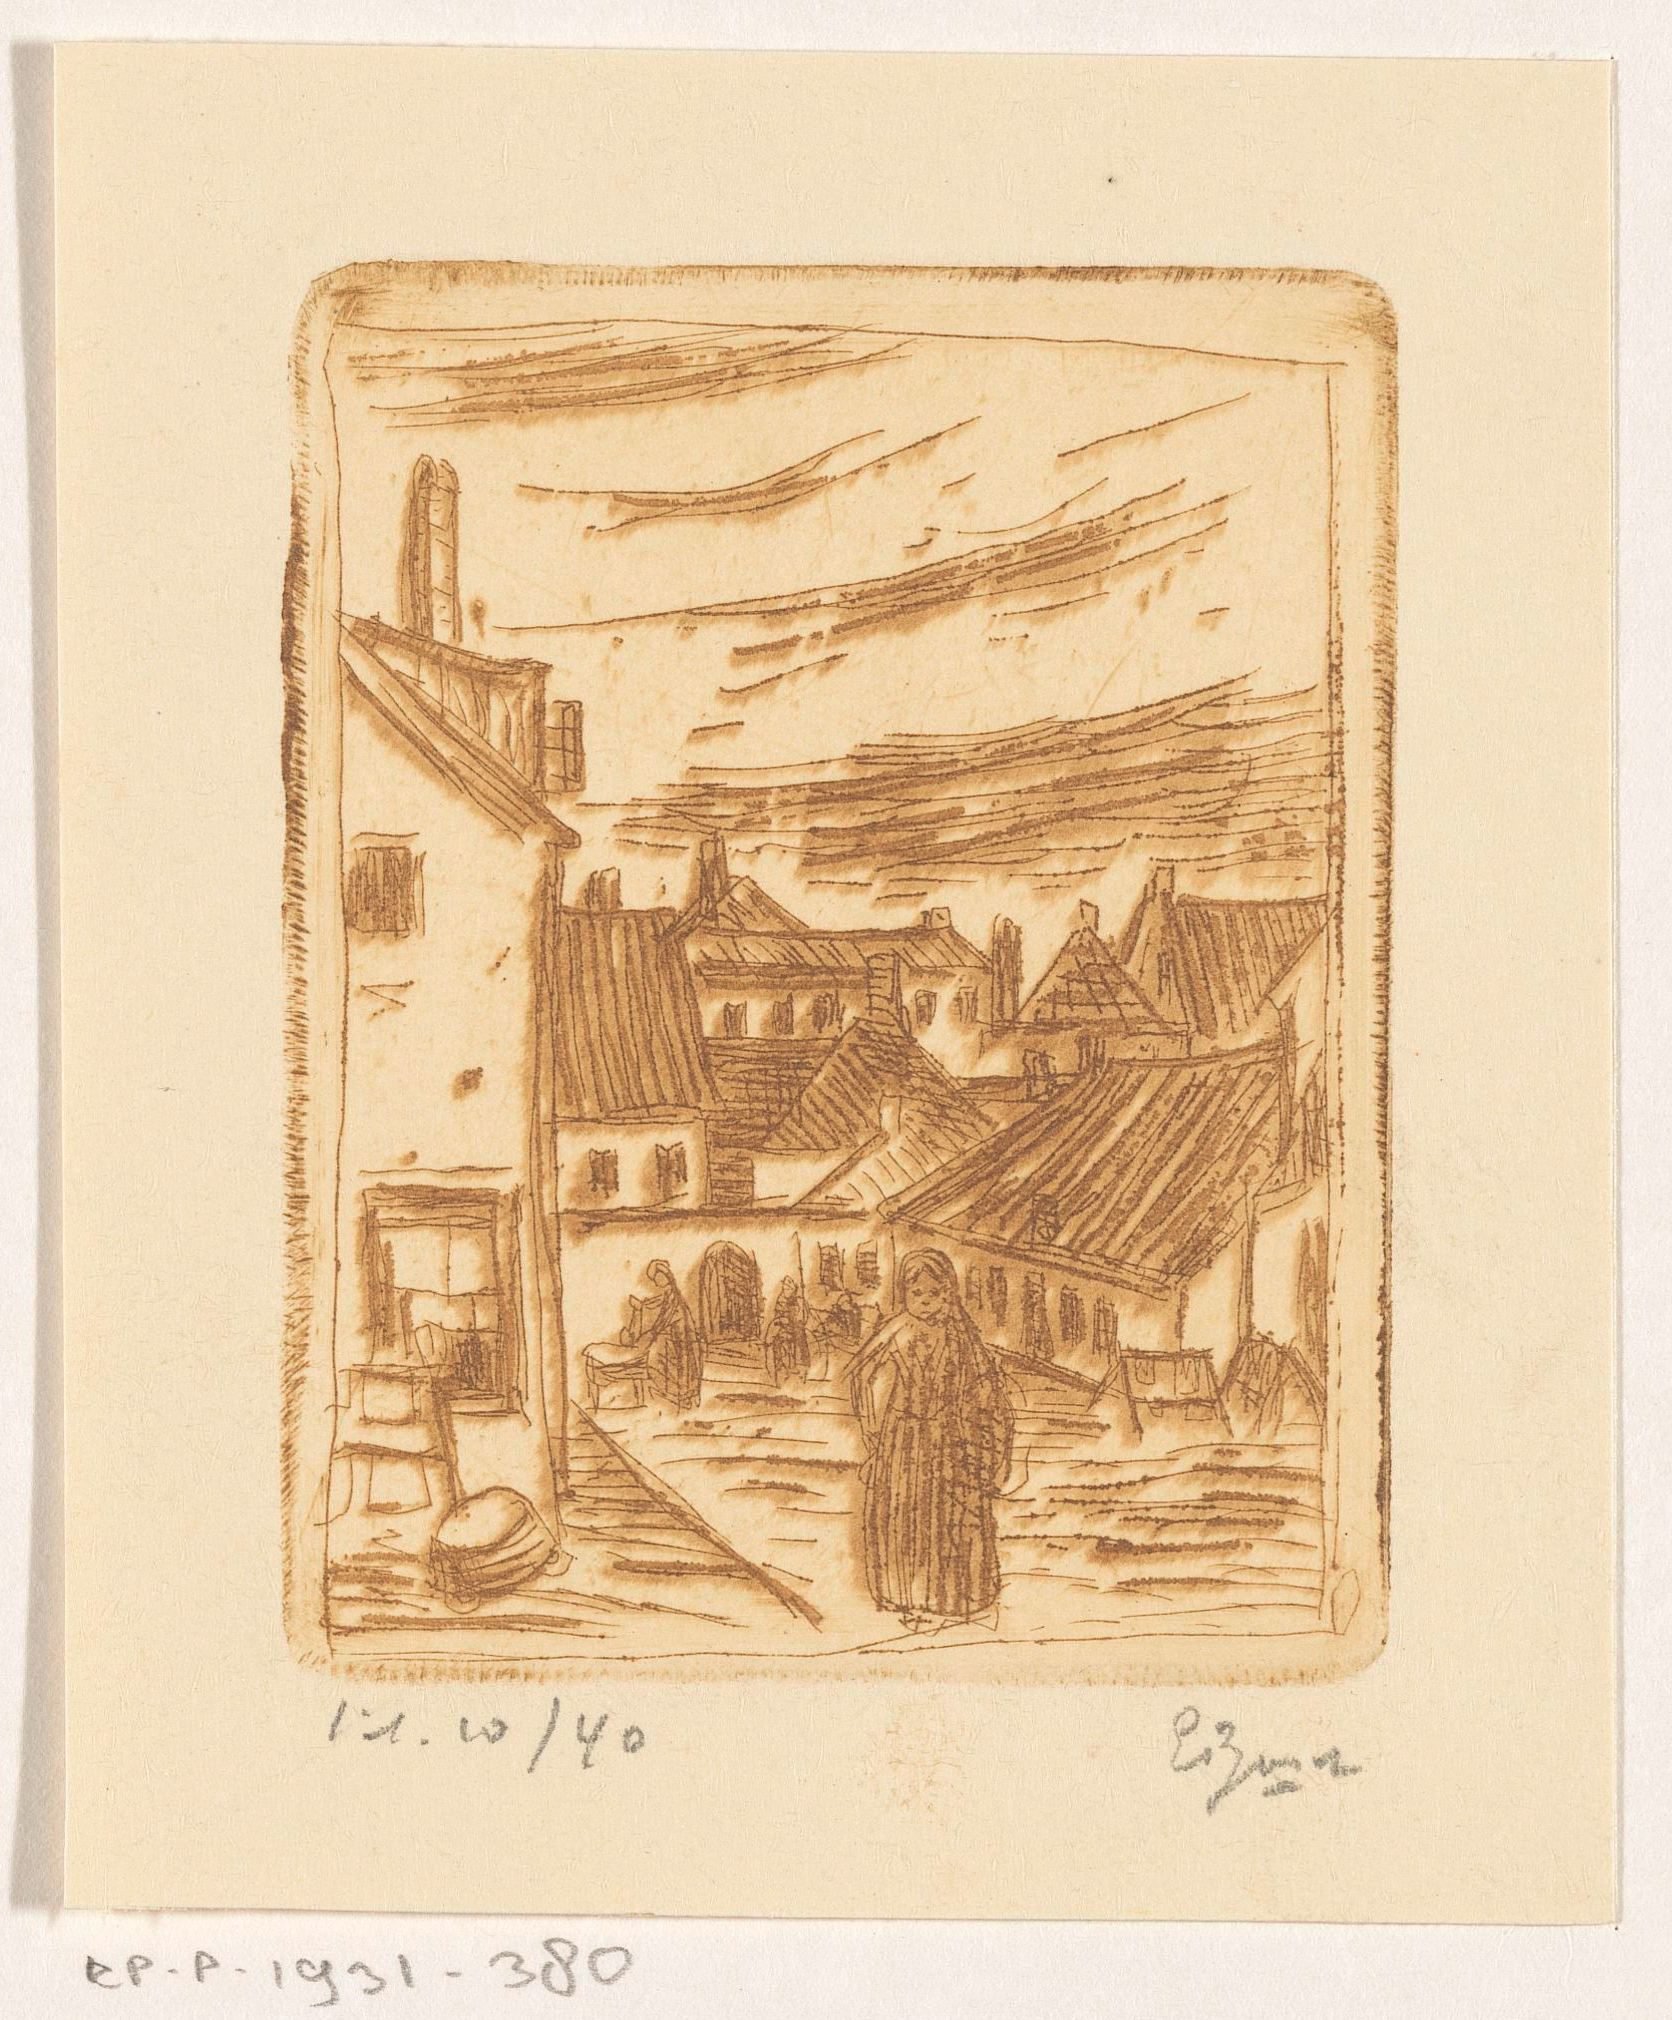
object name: print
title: Steeg Scheveningen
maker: etienne bosch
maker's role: print maker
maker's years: 1863-1933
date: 1873-1931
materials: paper, ink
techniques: drypoint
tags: scheveningen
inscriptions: collector's mark: Lugt 2228, edition: ‘1e et. 10/40’, signature: ‘EBosch’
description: Gezicht op een steeg en enkele huizen, met op de voorgrond een vrouw in een lange rok.